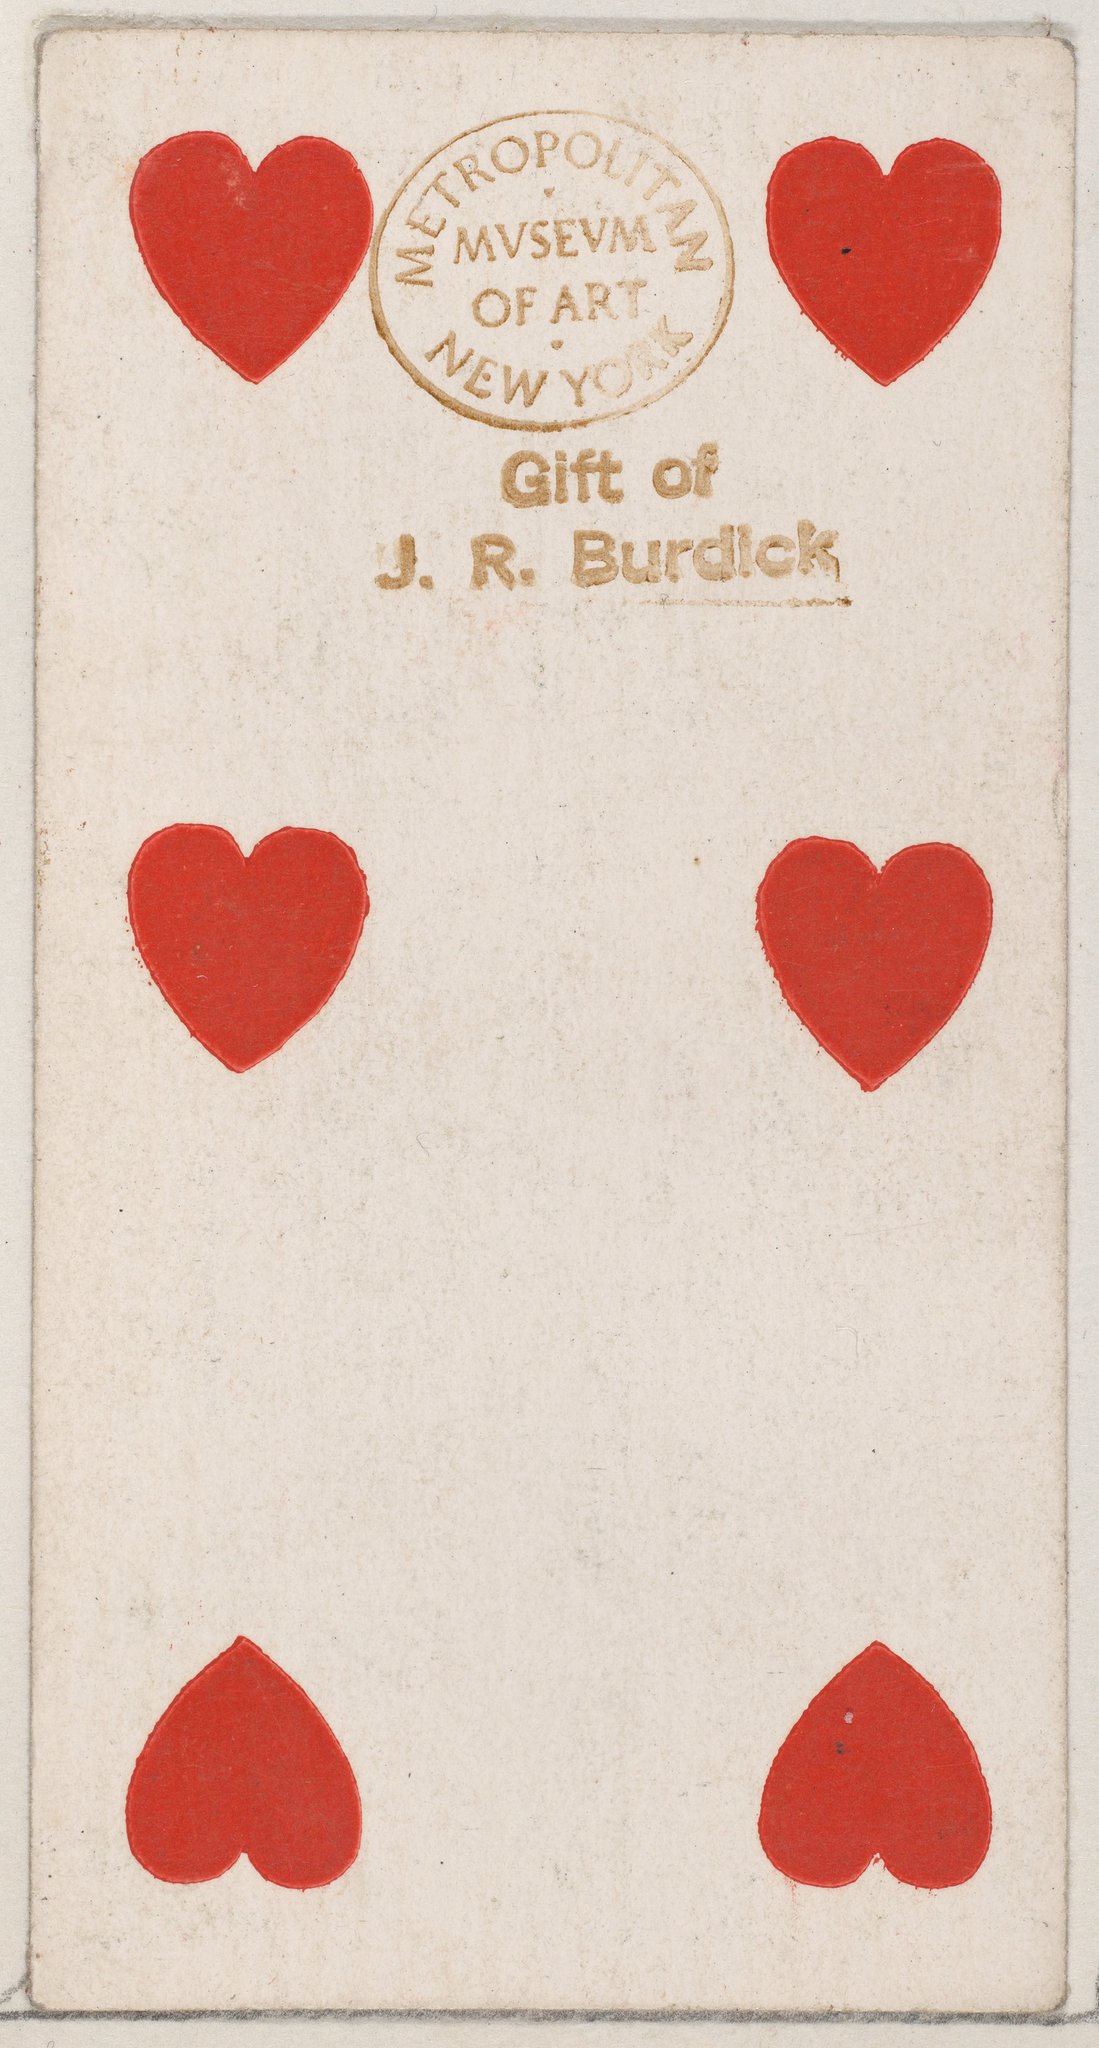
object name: print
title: Six Hearts, from the Playing Cards series (N84) to promote Turkish Cross-Cut Cigarettes for W. Duke, Sons and Co.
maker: w. duke, sons & co.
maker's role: publisher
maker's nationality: american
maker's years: 1870-1920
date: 1888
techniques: color lithograph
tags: playing cards